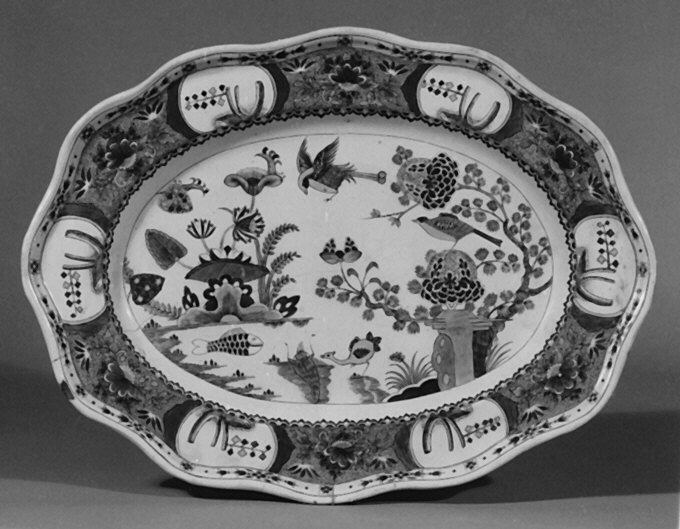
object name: dish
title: Oval dish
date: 1730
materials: earthenware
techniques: glazing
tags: birds,fish,flowers,trees